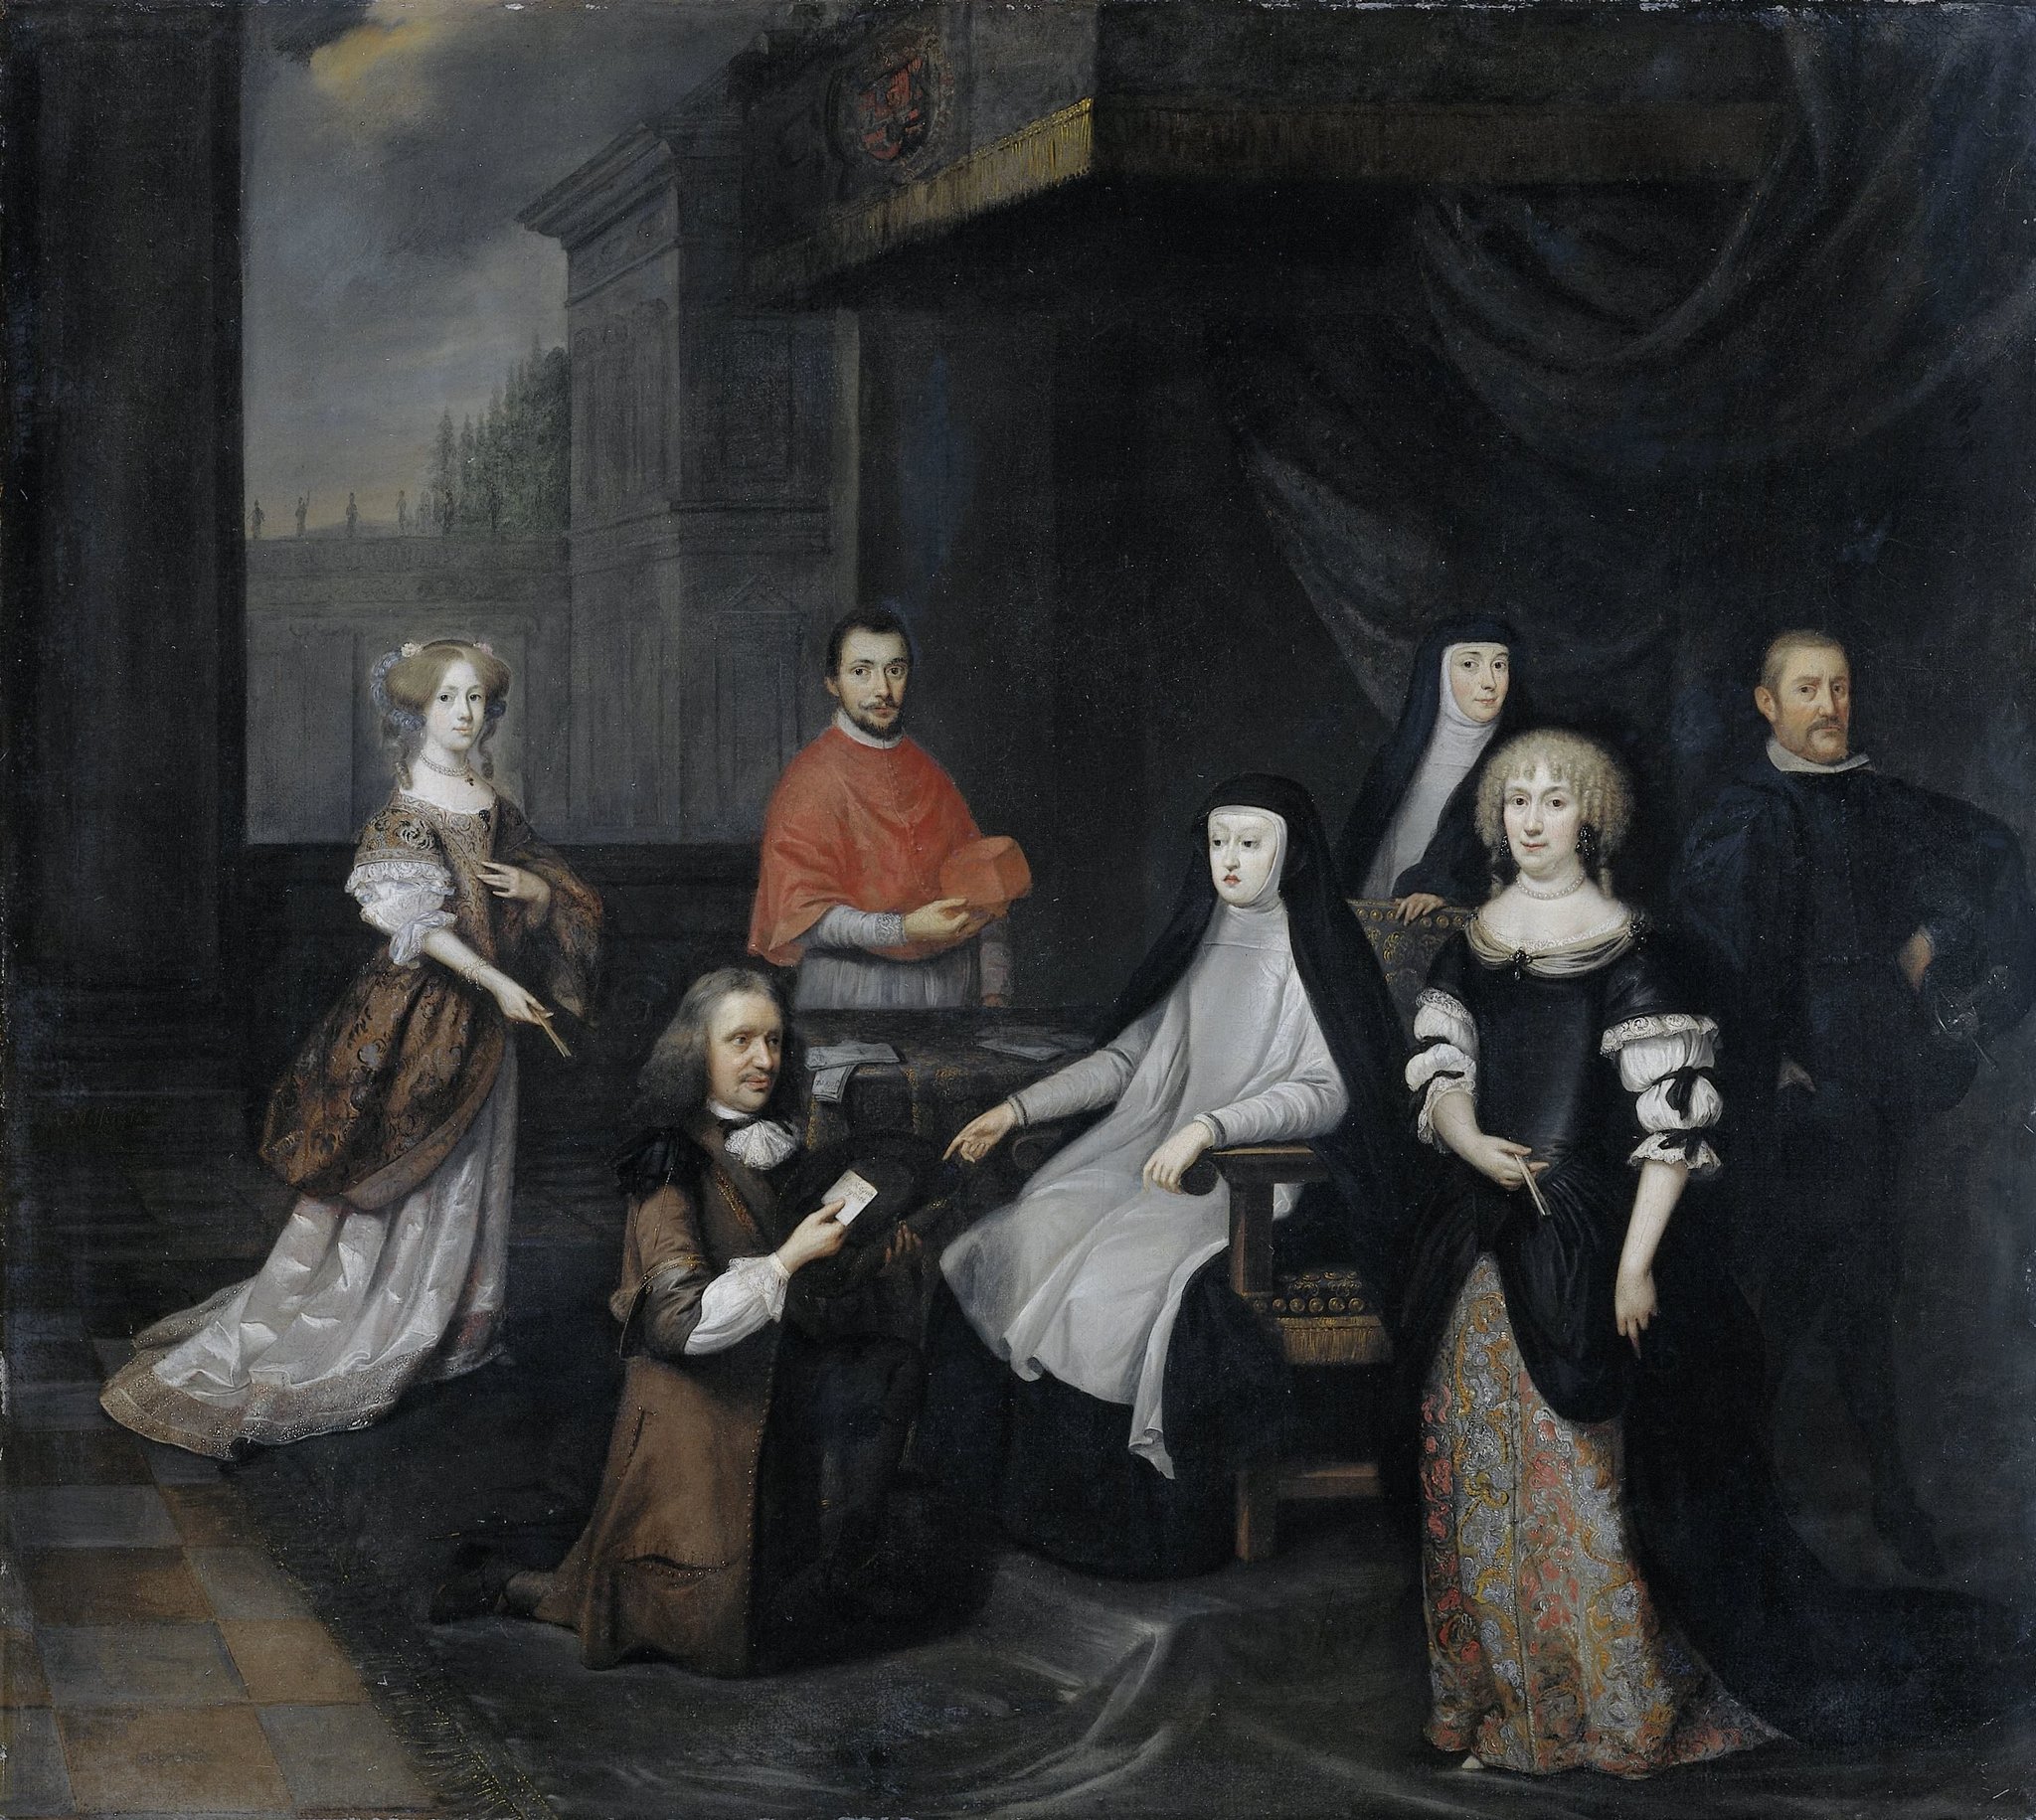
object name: painting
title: Reception of the Dutch ambassador Hieronymus van Beverningk by the Spanish queen-regent Maria-Anna of Austria, 2 March 1671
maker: caspar netscher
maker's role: draughtsman, painter, print maker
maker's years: 1639-1684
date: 1671-1675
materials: canvas, oil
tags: leiden, amsterdam, vienna, maria anna van oostenrijk (koningin van spanje), audition; ruler giving audience - bb - female ruler, spain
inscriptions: signature: ‘C. Netscher’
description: Reception of the Dutch ambassador Hieronymus van Beverningk by the Spanish queen-regent Maria-Anna of Austria, 2 March 1671, by Caspar Netscher. The expansionist policies of France's King Louis XIV forced the Republic to look for allies. In 1670 a pact was agreed with Spain. Maria Anna of Austria, the Spanish queen regent, received the Dutch diplomat Hieronymus van Beverningk in secret on 2 March 1671 in Madrid. The queen regent is dressed as an abbess (head of a convent). Standing behind the table is one of her advisors. The woman on the right in the foreground is Joanne le Gibbon, wife of Van Beverningk.